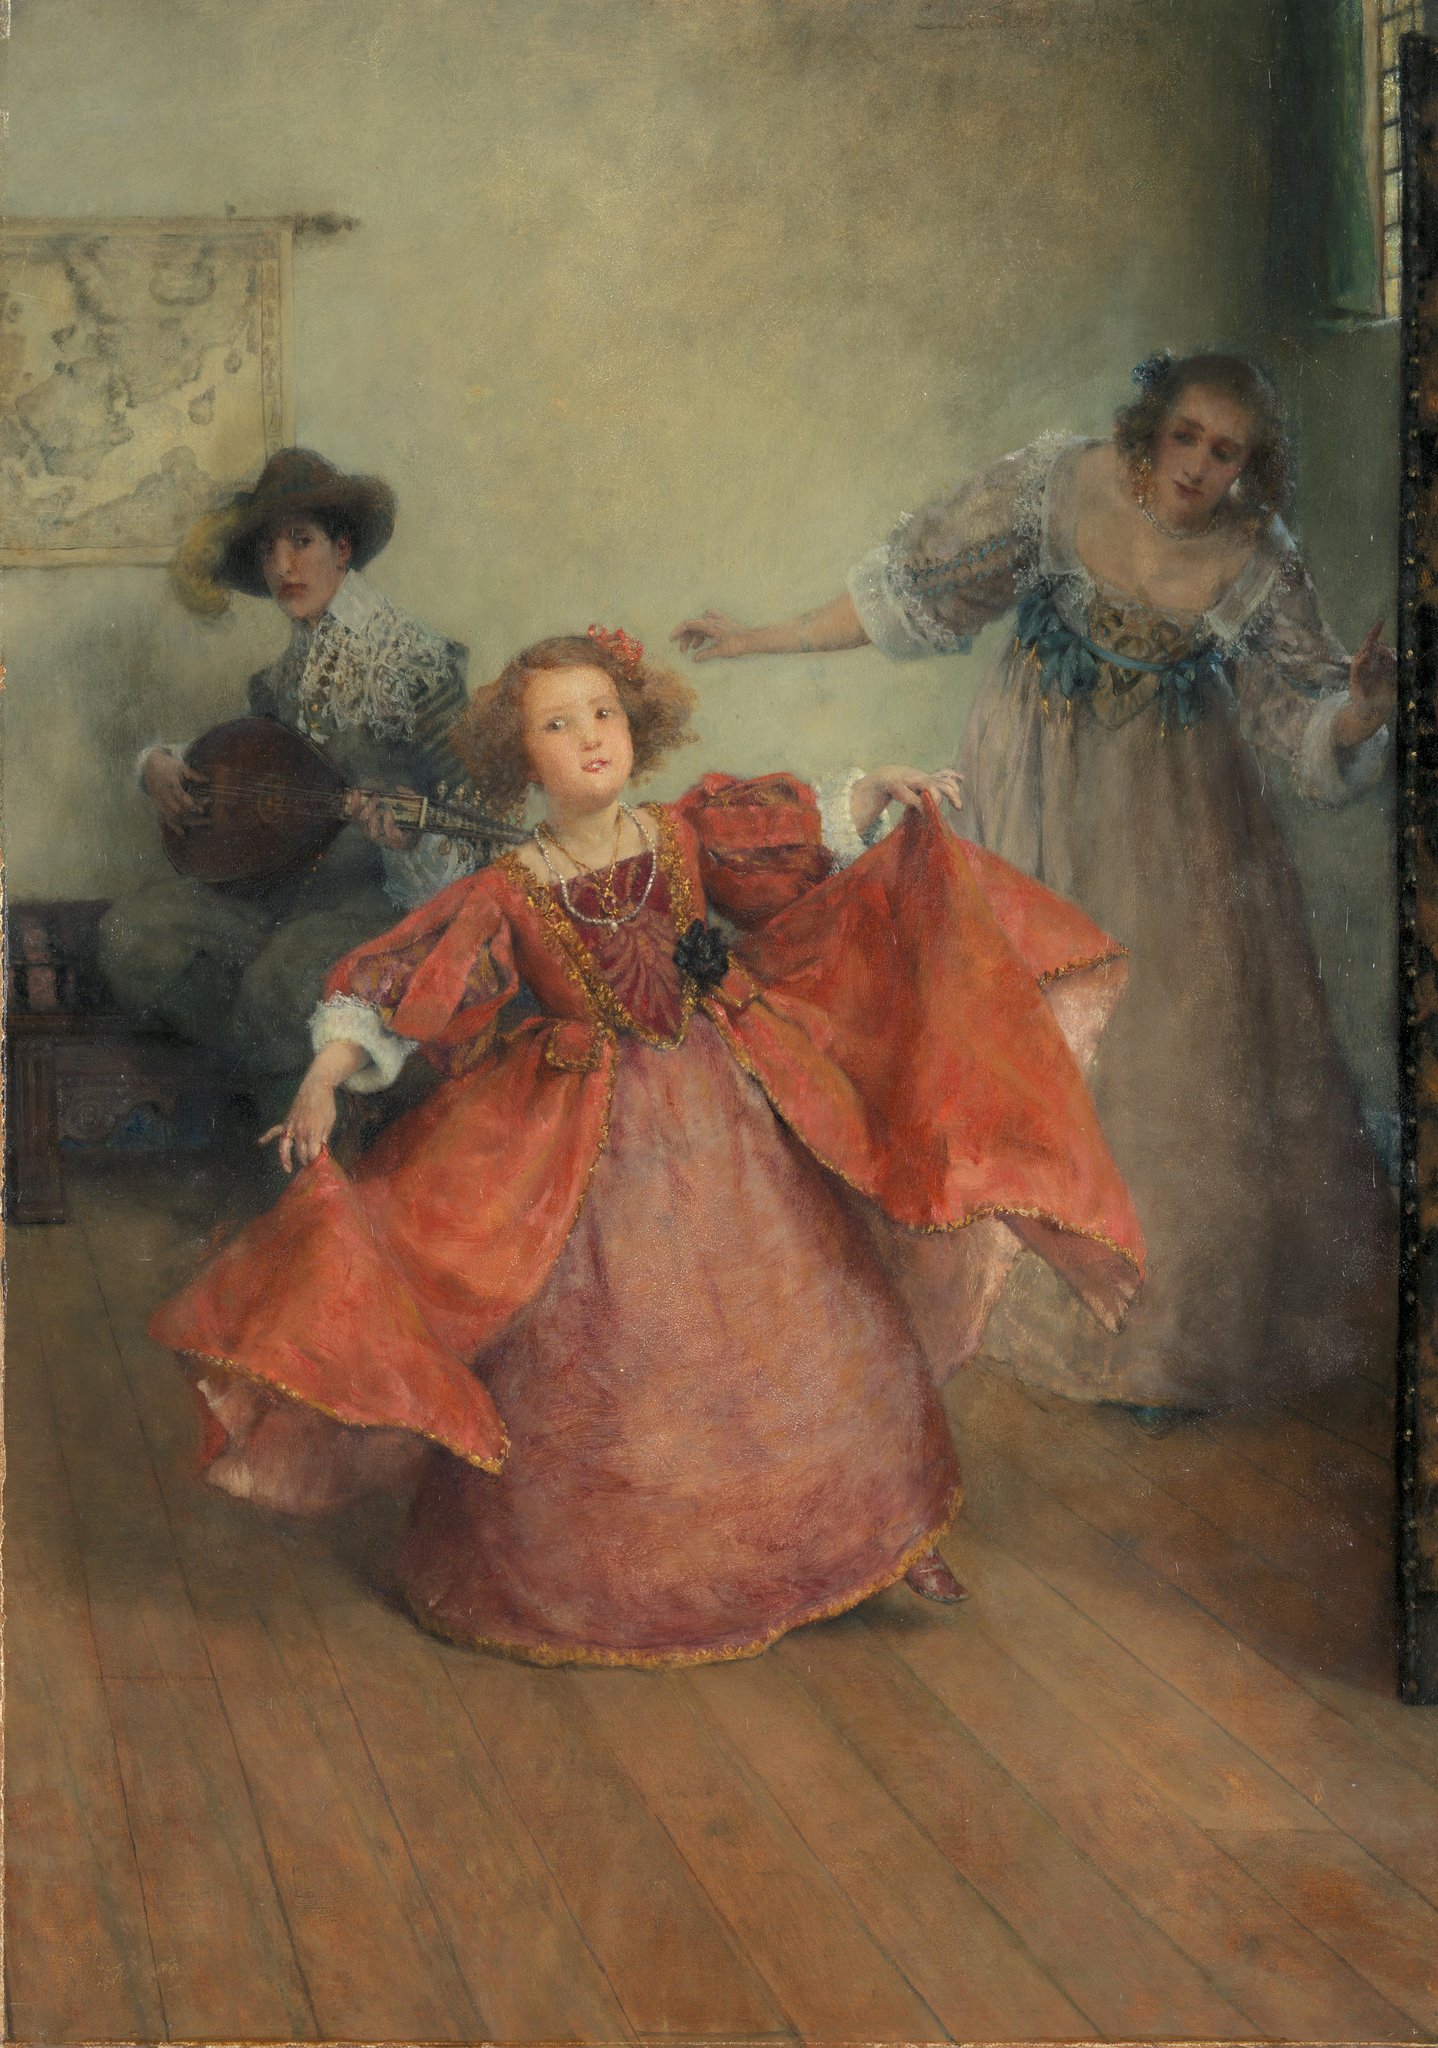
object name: painting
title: Airs and Graces, Opus CX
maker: laura theresa alma tadema (lady)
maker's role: painter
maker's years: 1852-1909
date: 1872-1909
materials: canvas, oil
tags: courtesy, manners; etiquette, woman dancing alone, one person playing string instrument (plucked)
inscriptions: inscription: ‘Op CX’, signature: ‘Laura Theresa Alma Tadema’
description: A girl dances around the room while her mother and a man playing a lute look on. The clothes, jewellery, and setting are clearly inspired by 17th-century Dutch paintings, although Alma Tadema gave them her own twist. Her works in this style met with international success. The light streaming in and the map on the wall are reminiscent of paintings by Vermeer, who was rediscovered at this time.